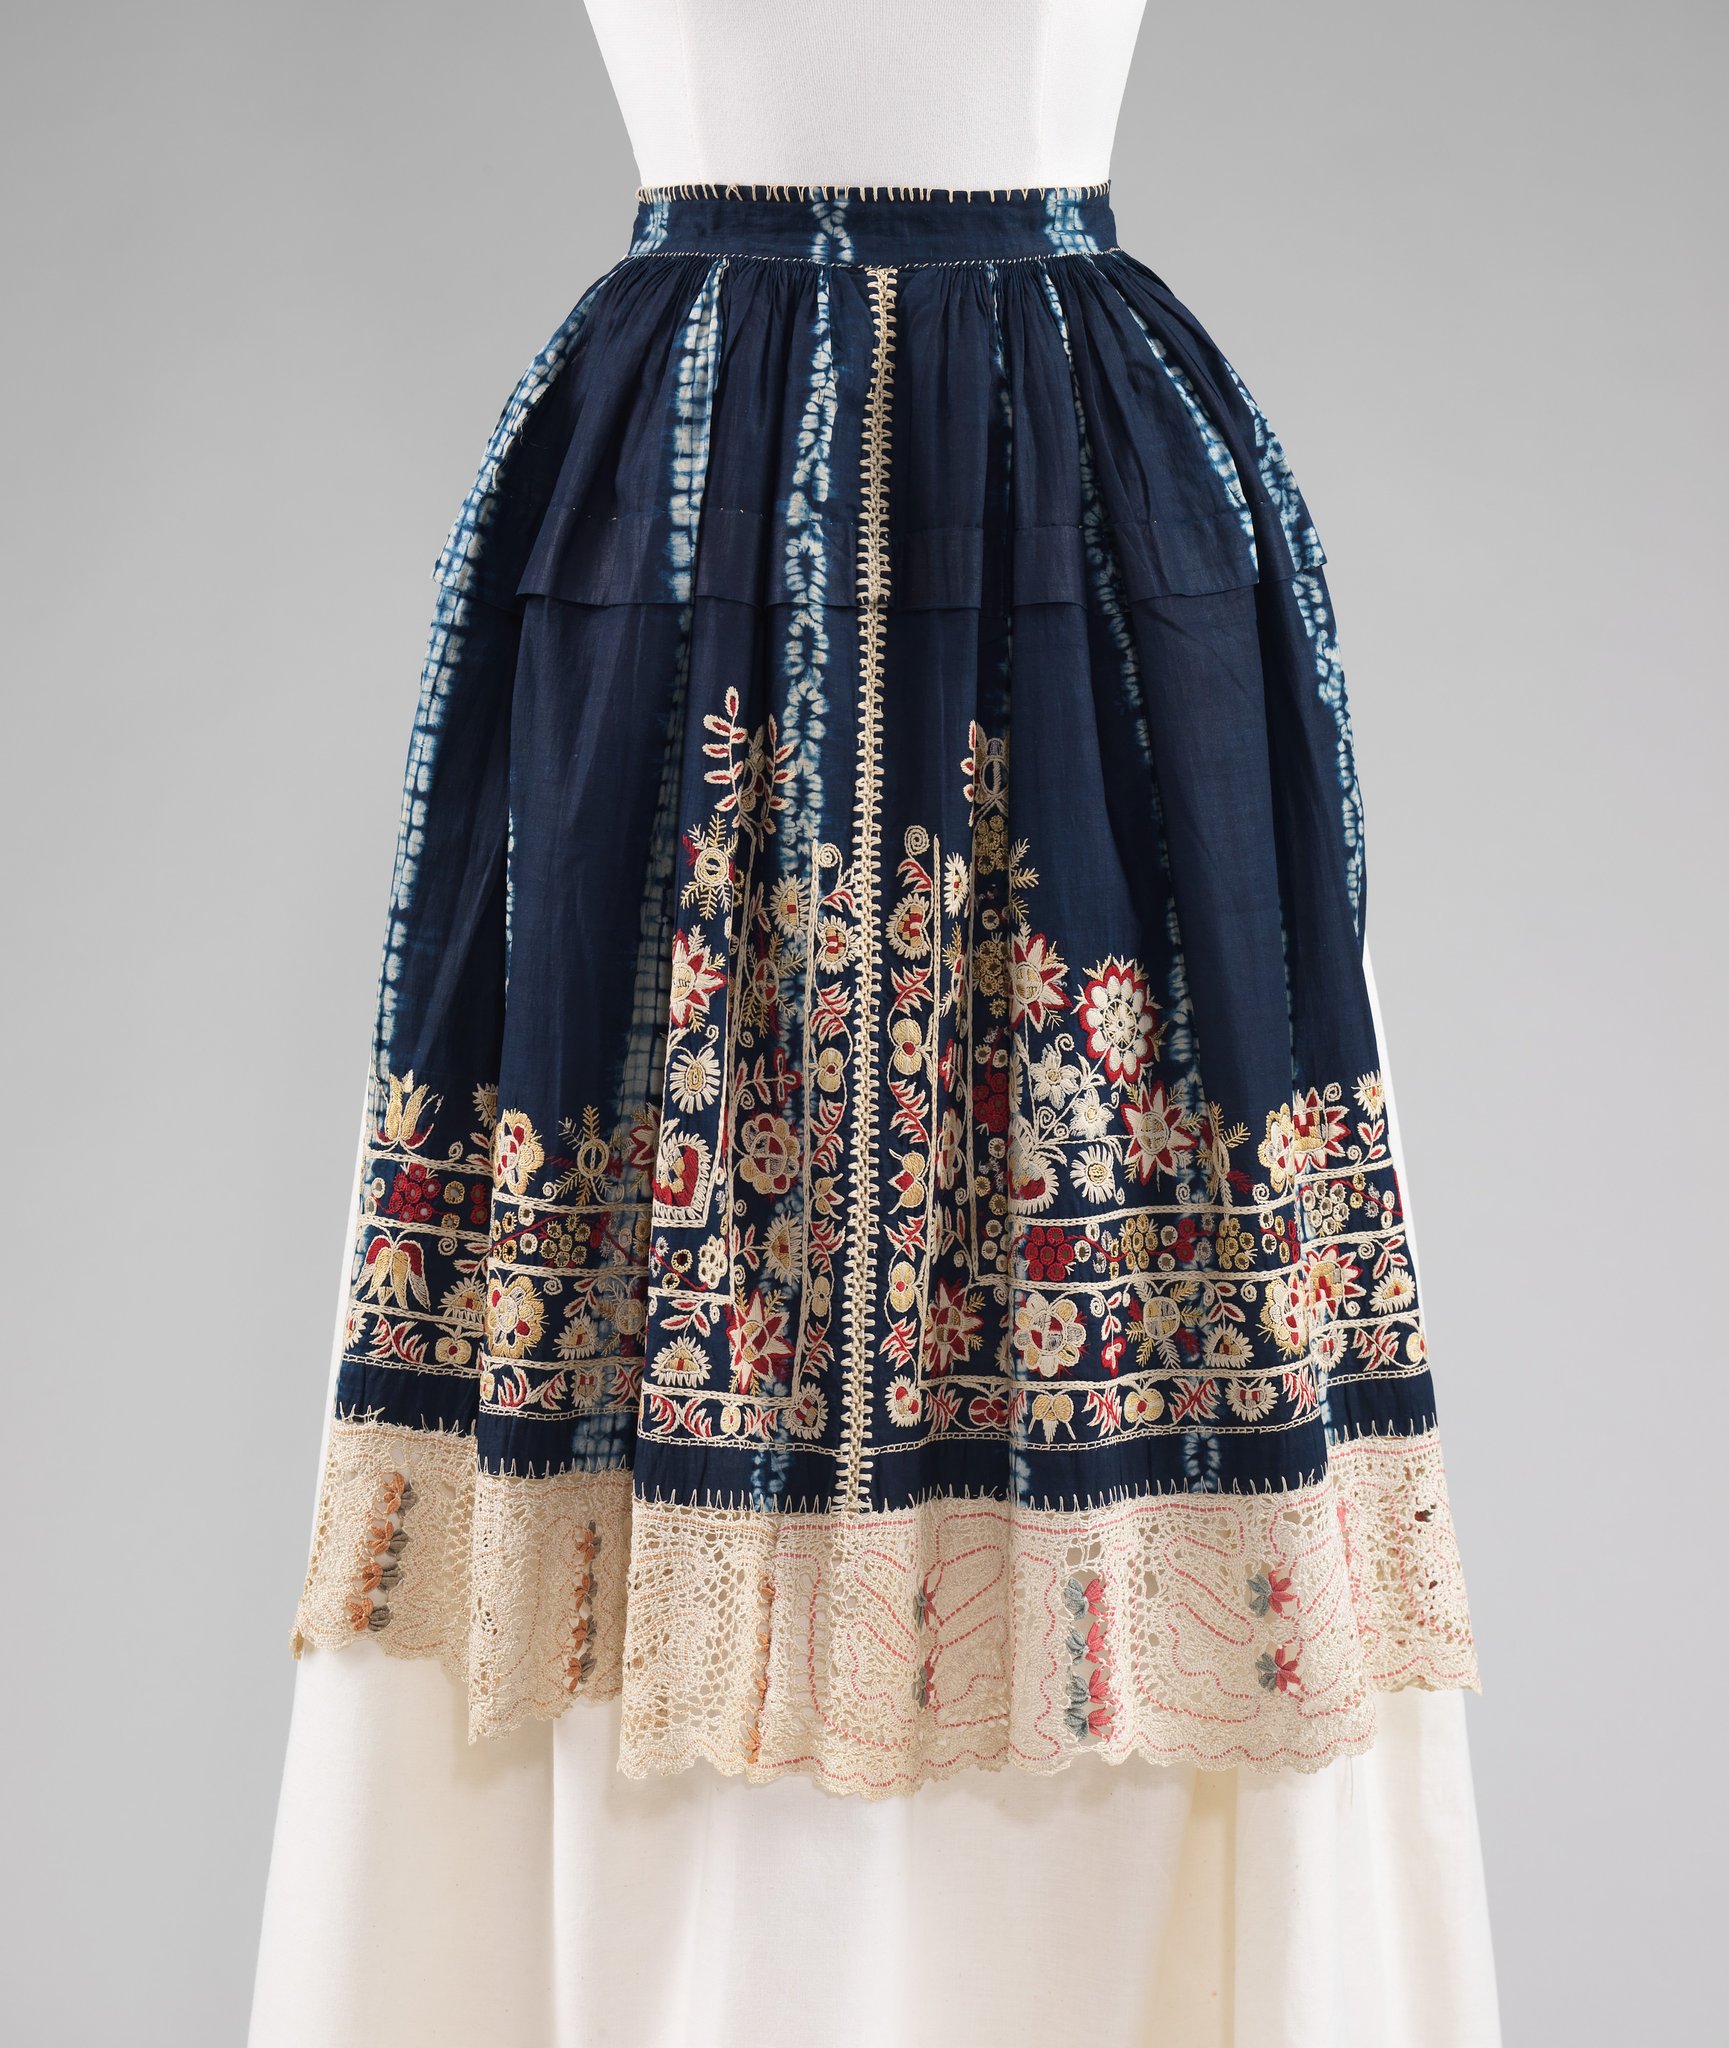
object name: apron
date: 1876-1900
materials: cotton, silk, wool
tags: flowers